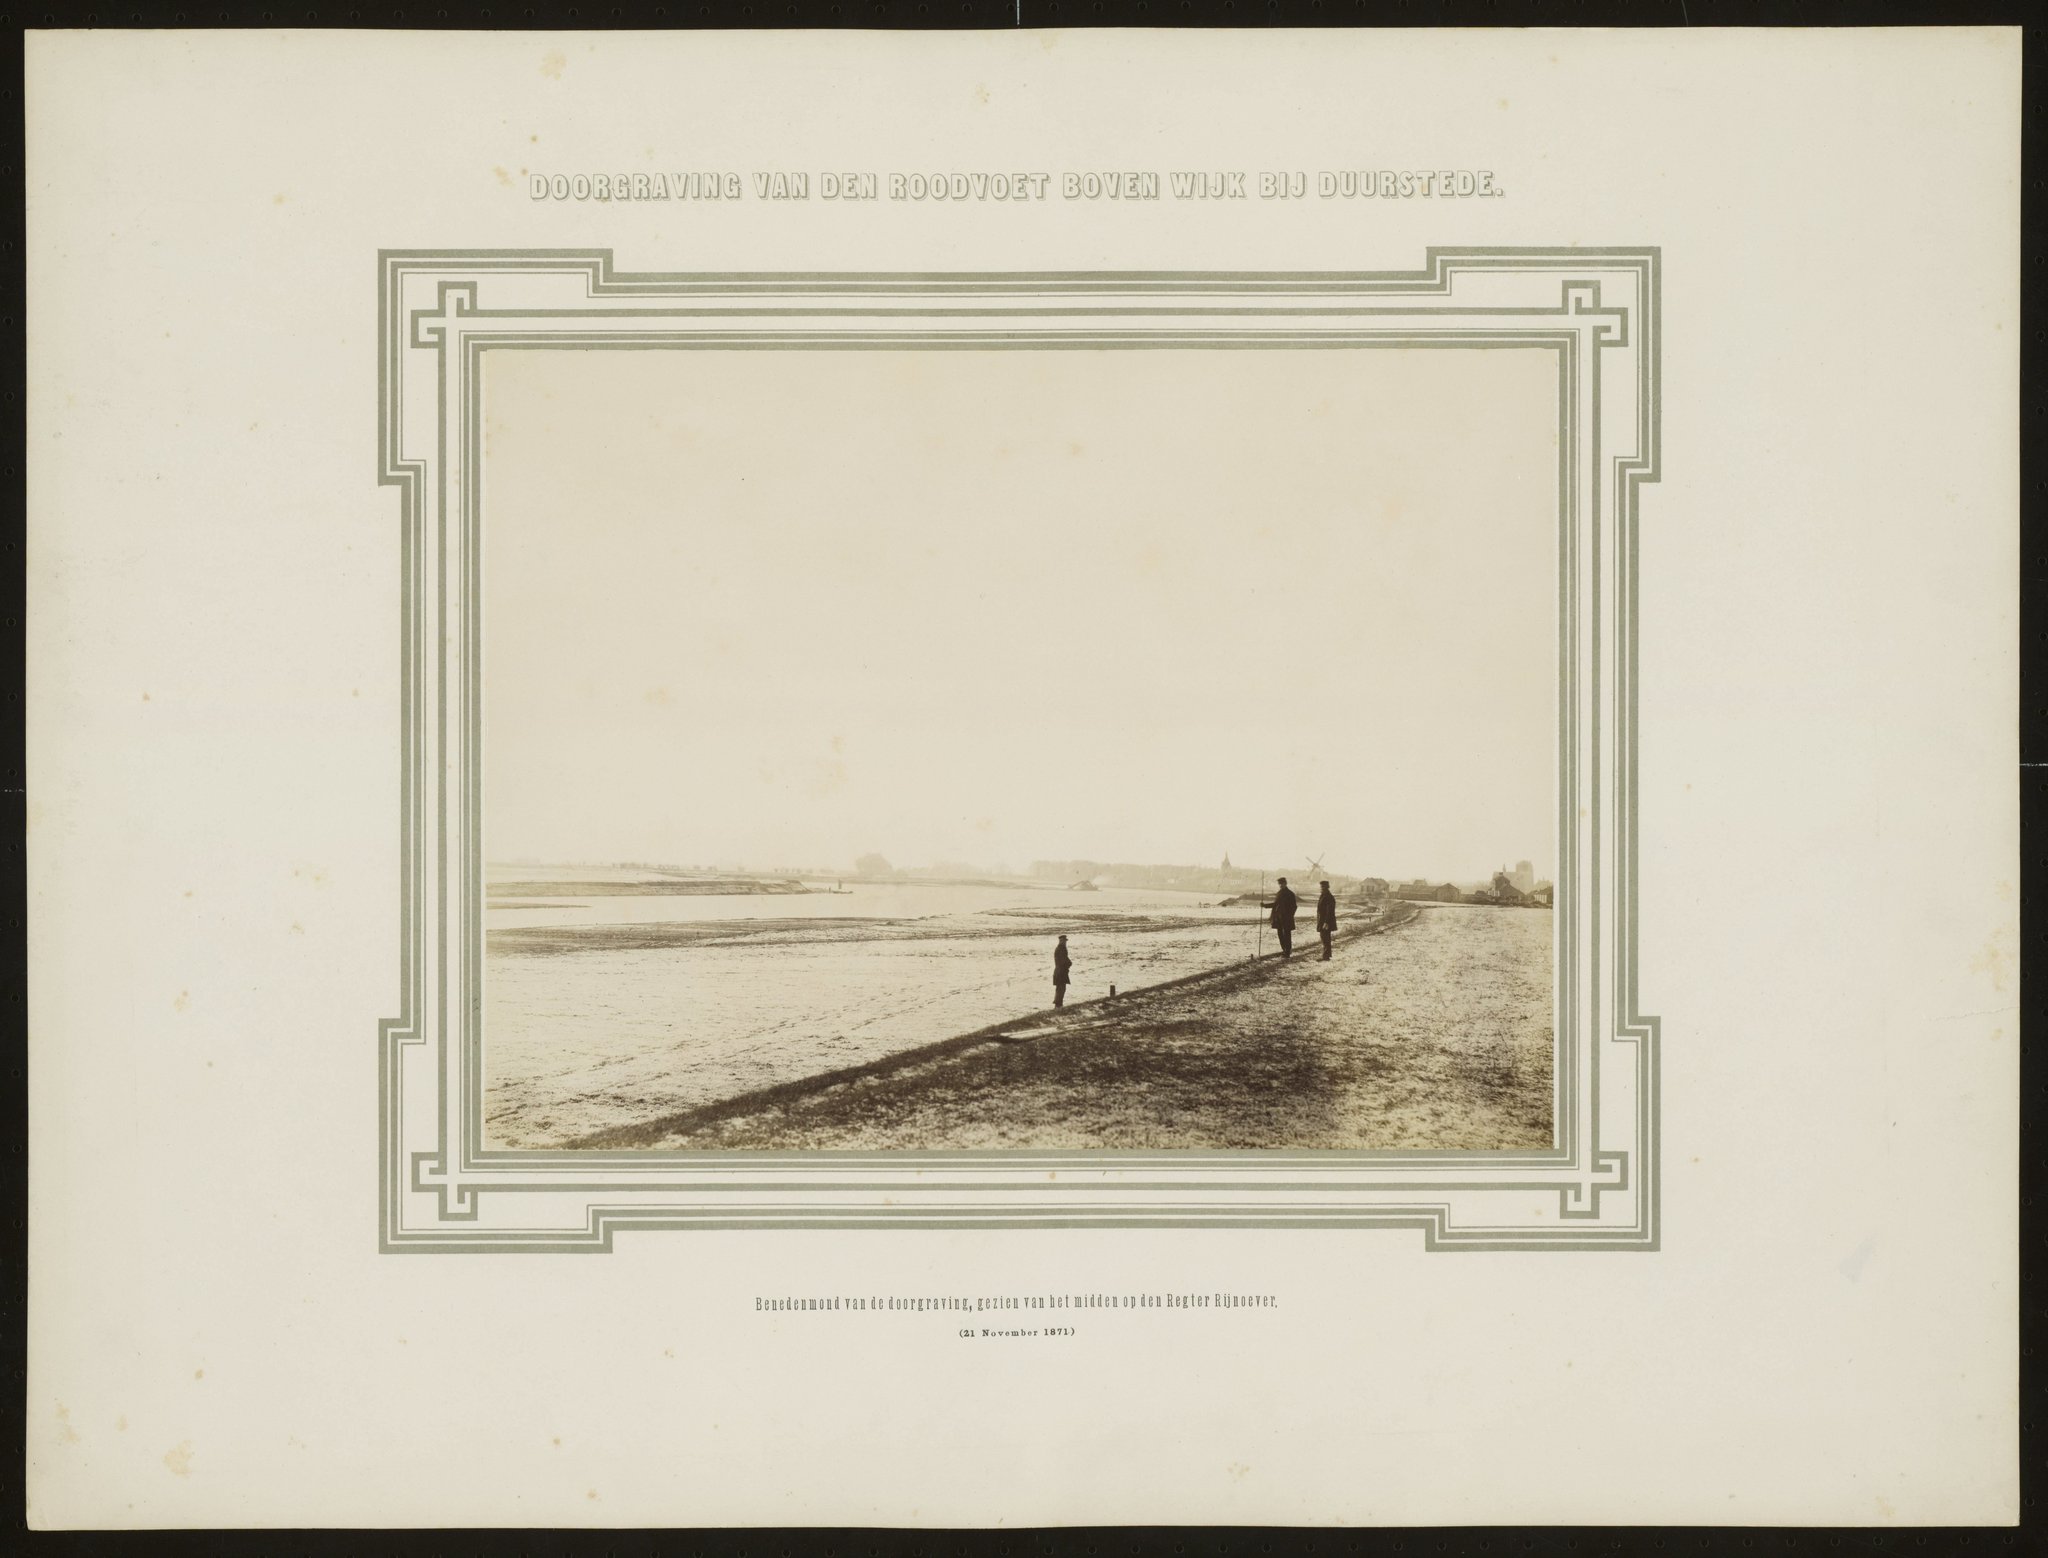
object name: photograph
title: Benedenmond van de doorgraving, gezien van het midden op den Regter Rijnoever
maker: Anonymous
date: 1871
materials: cardboard, paper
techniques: photography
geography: wijk bij duurstede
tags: wijk bij duurstede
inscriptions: date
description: Foto op karton van waterbouwkundige werkzaamheden aan een kanaal.